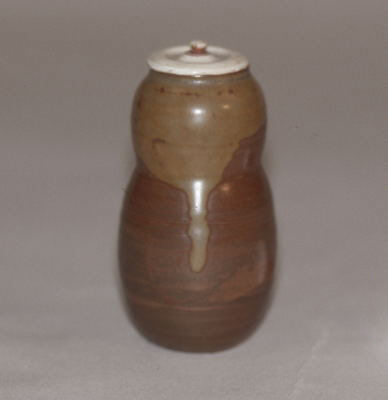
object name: tea jar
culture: japanese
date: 1701-1800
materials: clay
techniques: overglaze